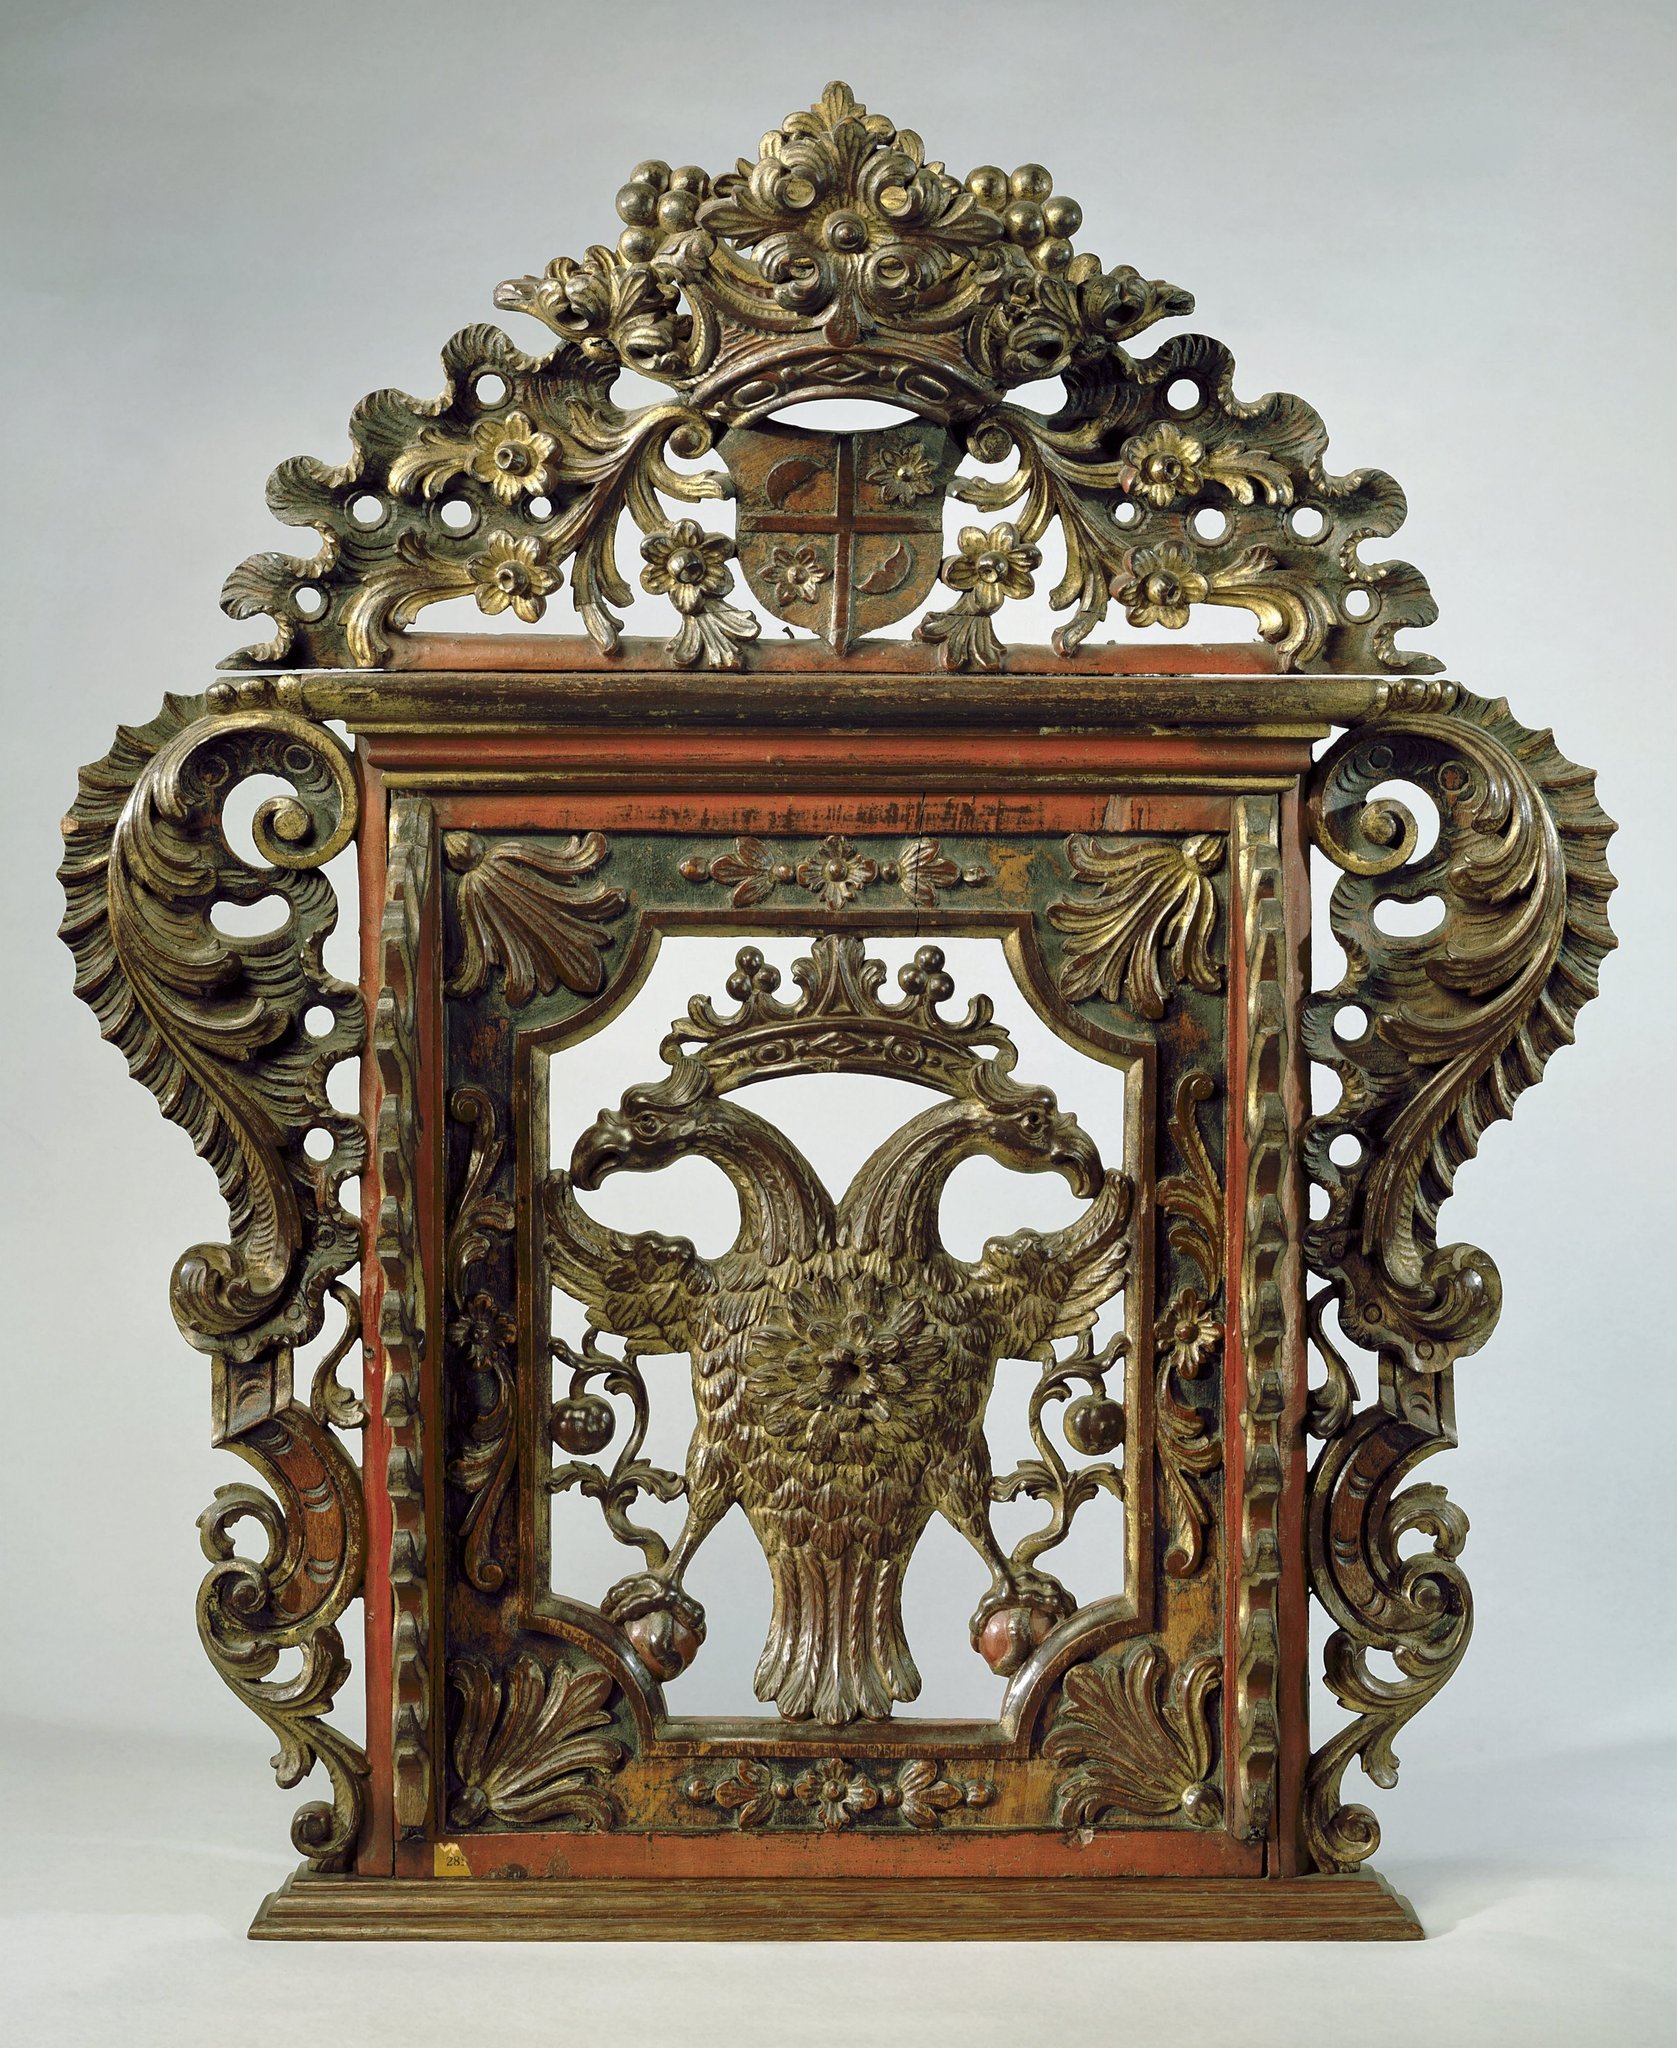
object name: pipe rack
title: Gesneden pijpenrek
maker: Anonymous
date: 1600-1699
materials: paint, wood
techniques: gilding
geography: batavia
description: Pipe rack. Gilded and painted teak. Indonesia, c. 1725 - 1750.